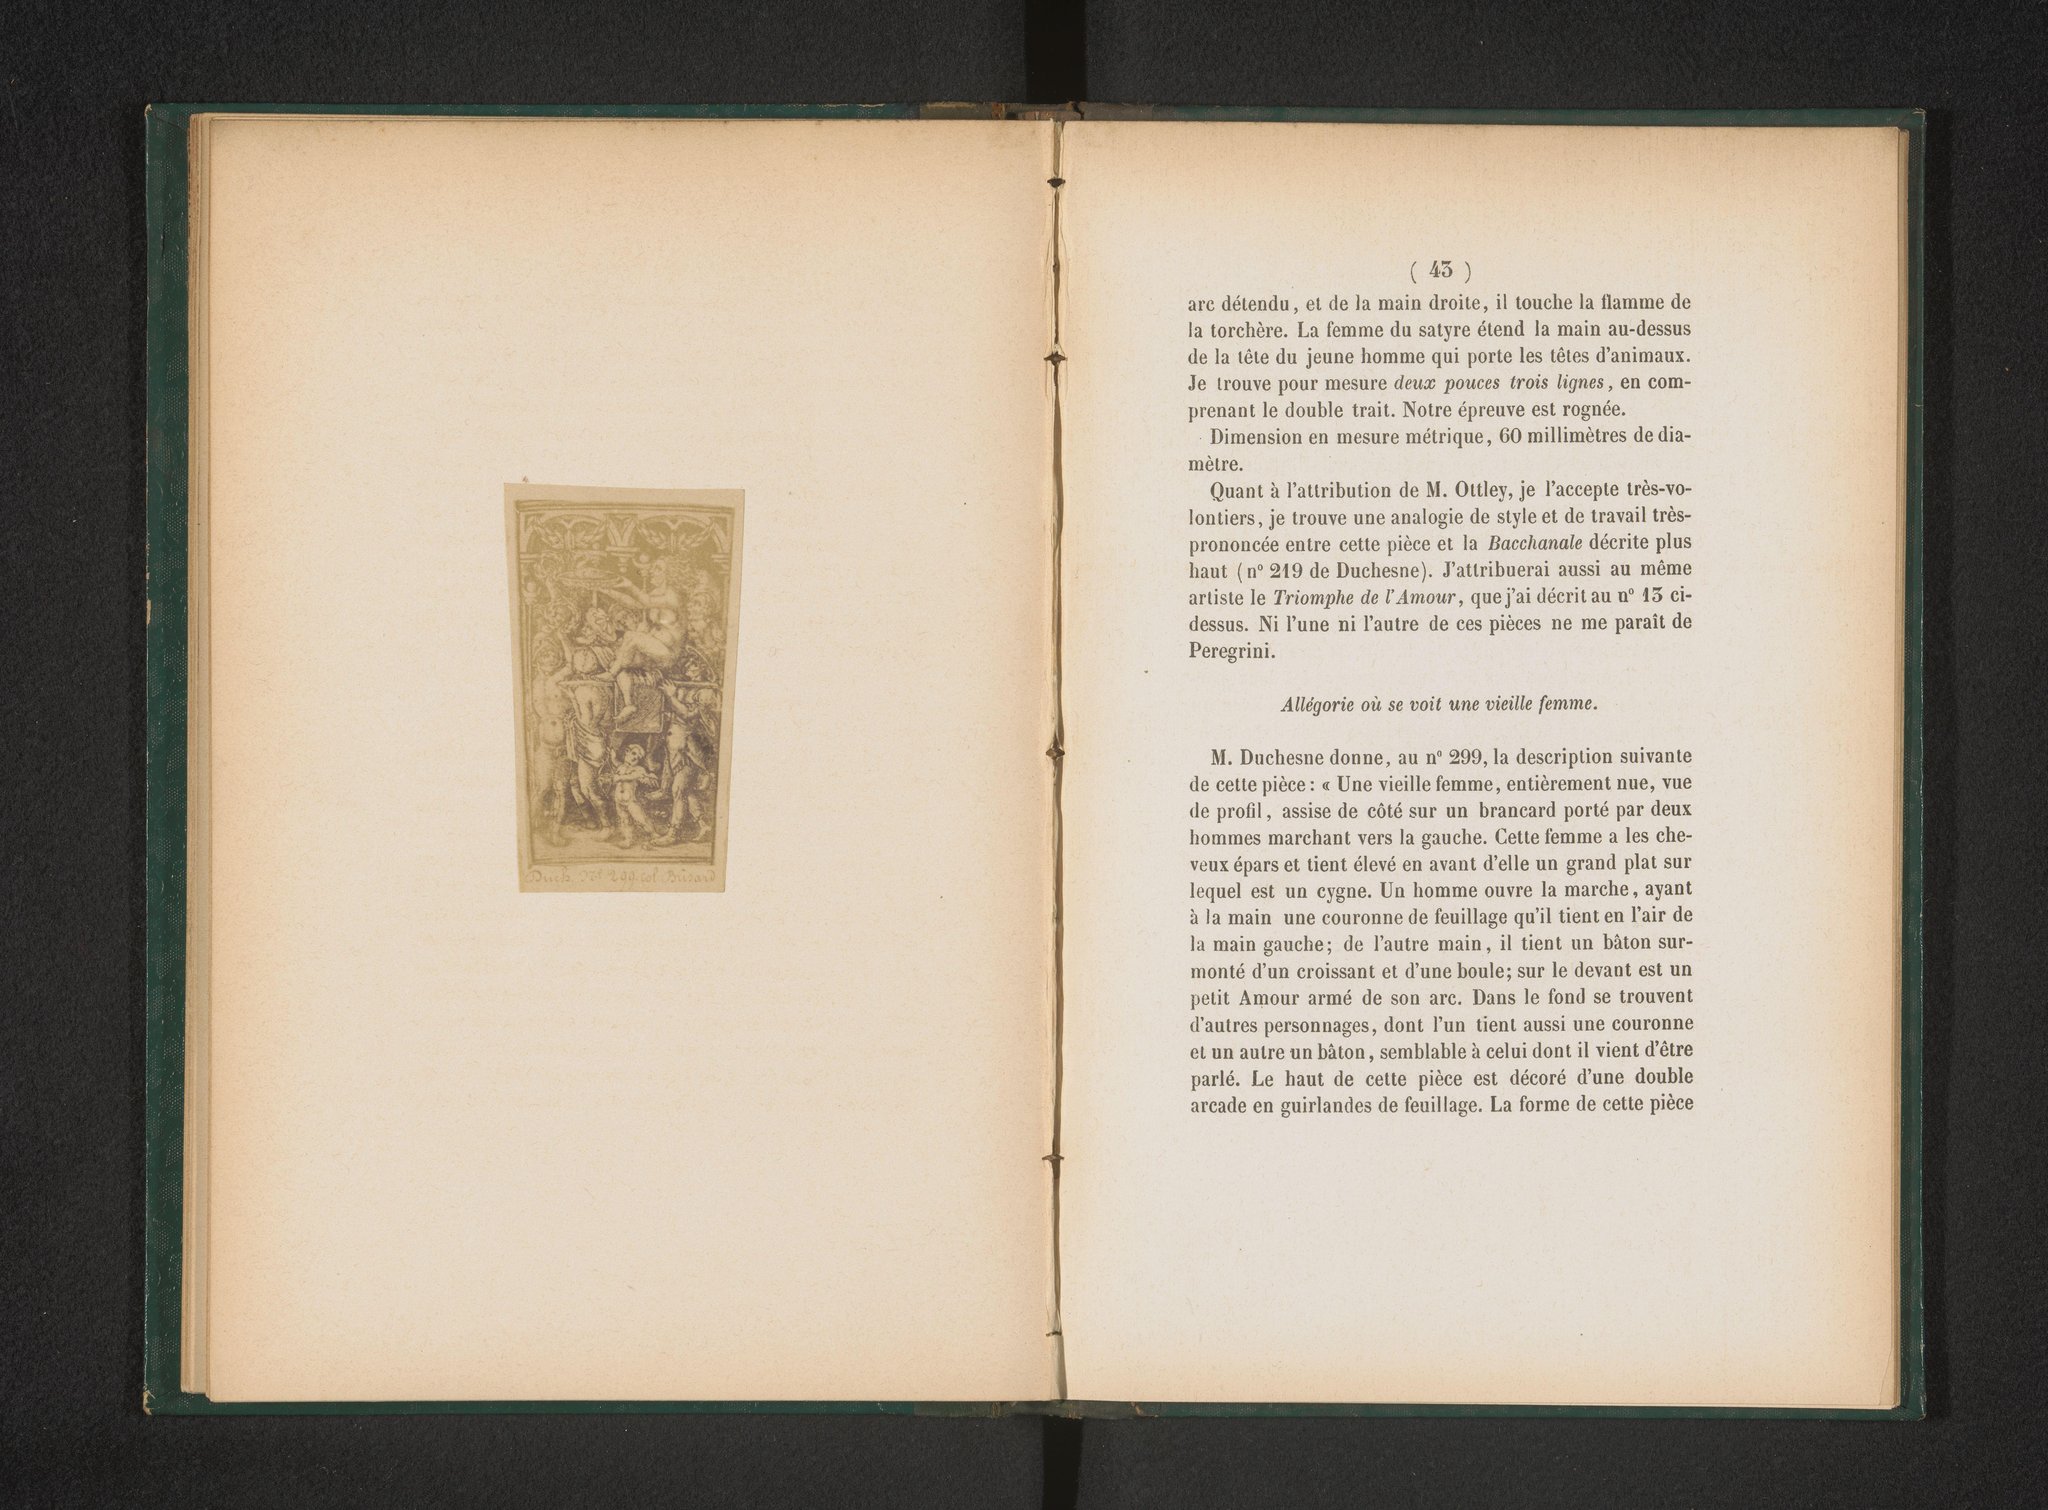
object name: photograph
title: Fotoreproductie van een prent van een allegorie met een oude vrouw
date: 1852-1857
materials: photographic support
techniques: salted paper print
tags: old woman, symbolic representations, allegories and emblems ~ drawing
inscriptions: inscription: ‘Duch. No. 299. col Brisard’